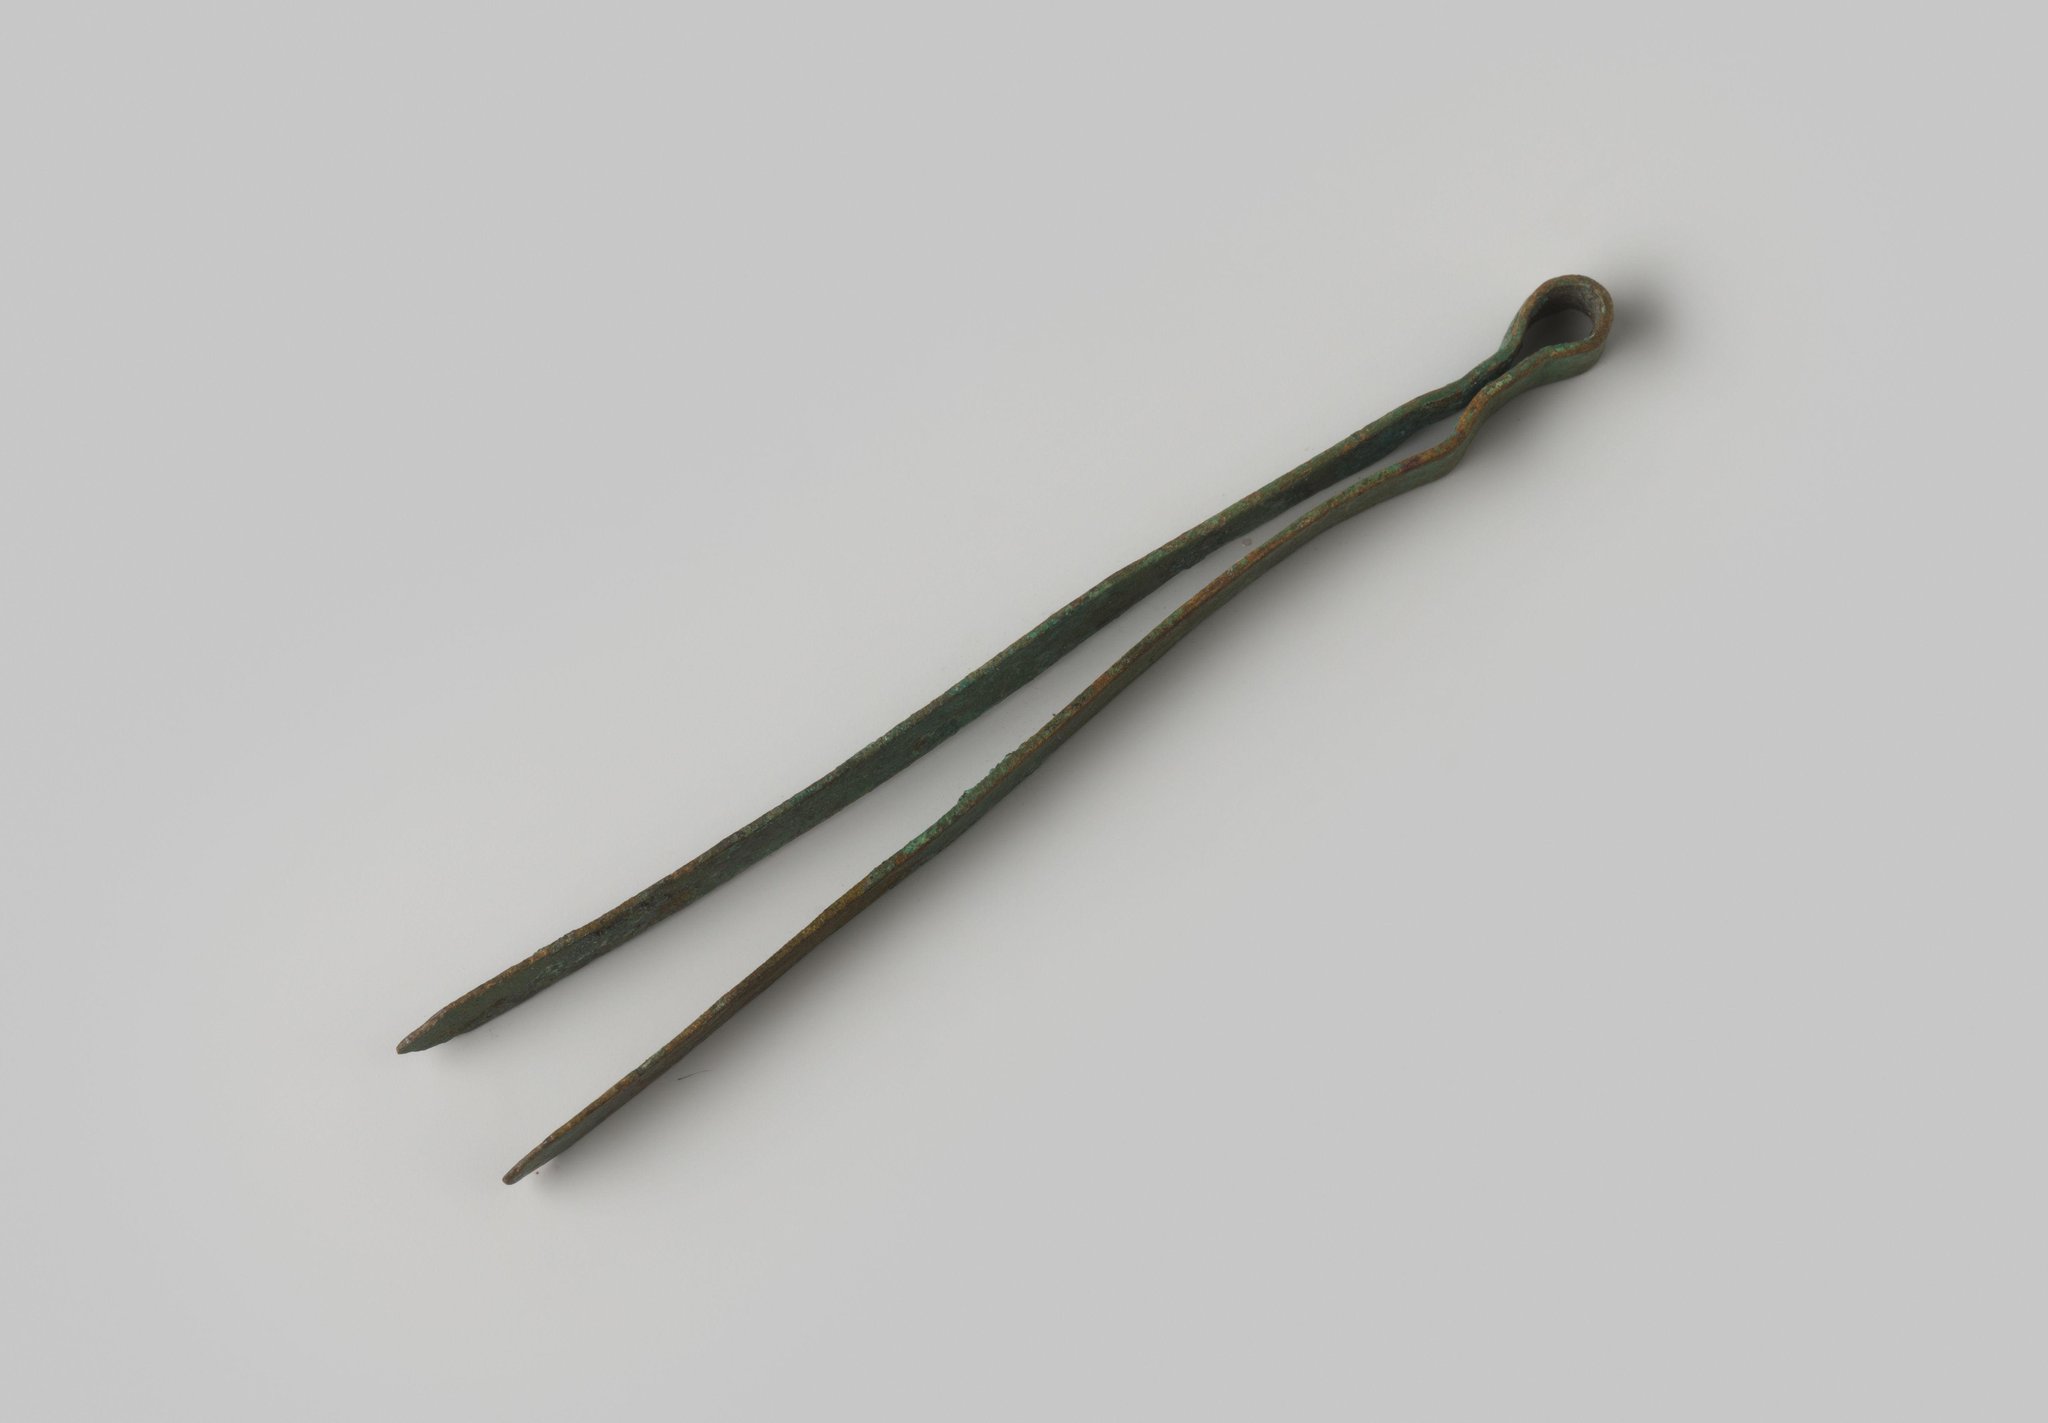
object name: snuiter, snuiterschaar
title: Onderdeel snuiter uit het wrak van de Oost-Indiëvaarder Hollandia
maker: Anonymous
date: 1700-1743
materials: copper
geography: netherlands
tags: verenigde oostindische compagnie, hollandia (schip), annet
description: Wick trimmer; tongs, consisting of a folded strip, with a circular loop at the upper end, both lower ends pointed.